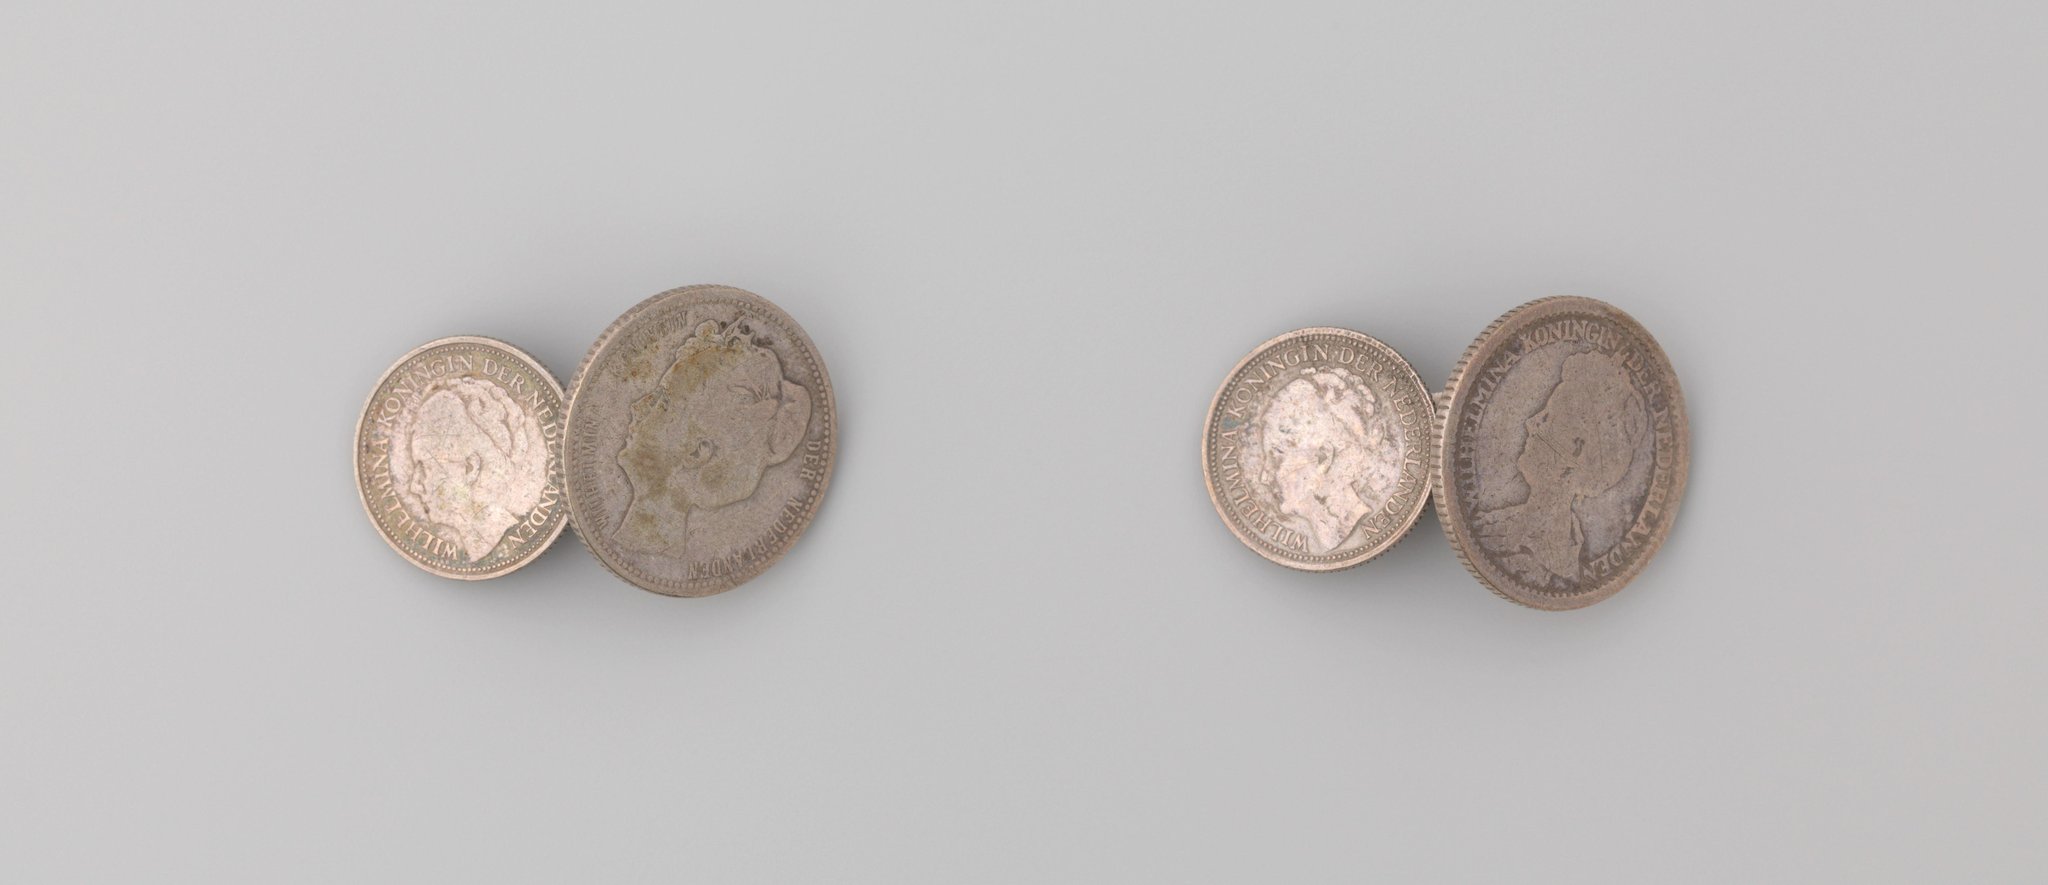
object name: cuff link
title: Manchetknoop van Nederlandse zilveren munten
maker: a.j. fibbe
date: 1944-1950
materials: silver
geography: rotterdam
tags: the hague, print maker, wilhelmina of the netherlands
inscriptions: maker's mark: ‘xAF.x’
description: Manchetknoop van Nederlandse zilveren munten. De knoop bestaat uit een dubbeltje en een kwartje met de beeldenaar van Wilhelmina. Aan het kwartje zit een stijf verbindingsstuk dat is gekoppeld aan een oog op het dubbeltje.